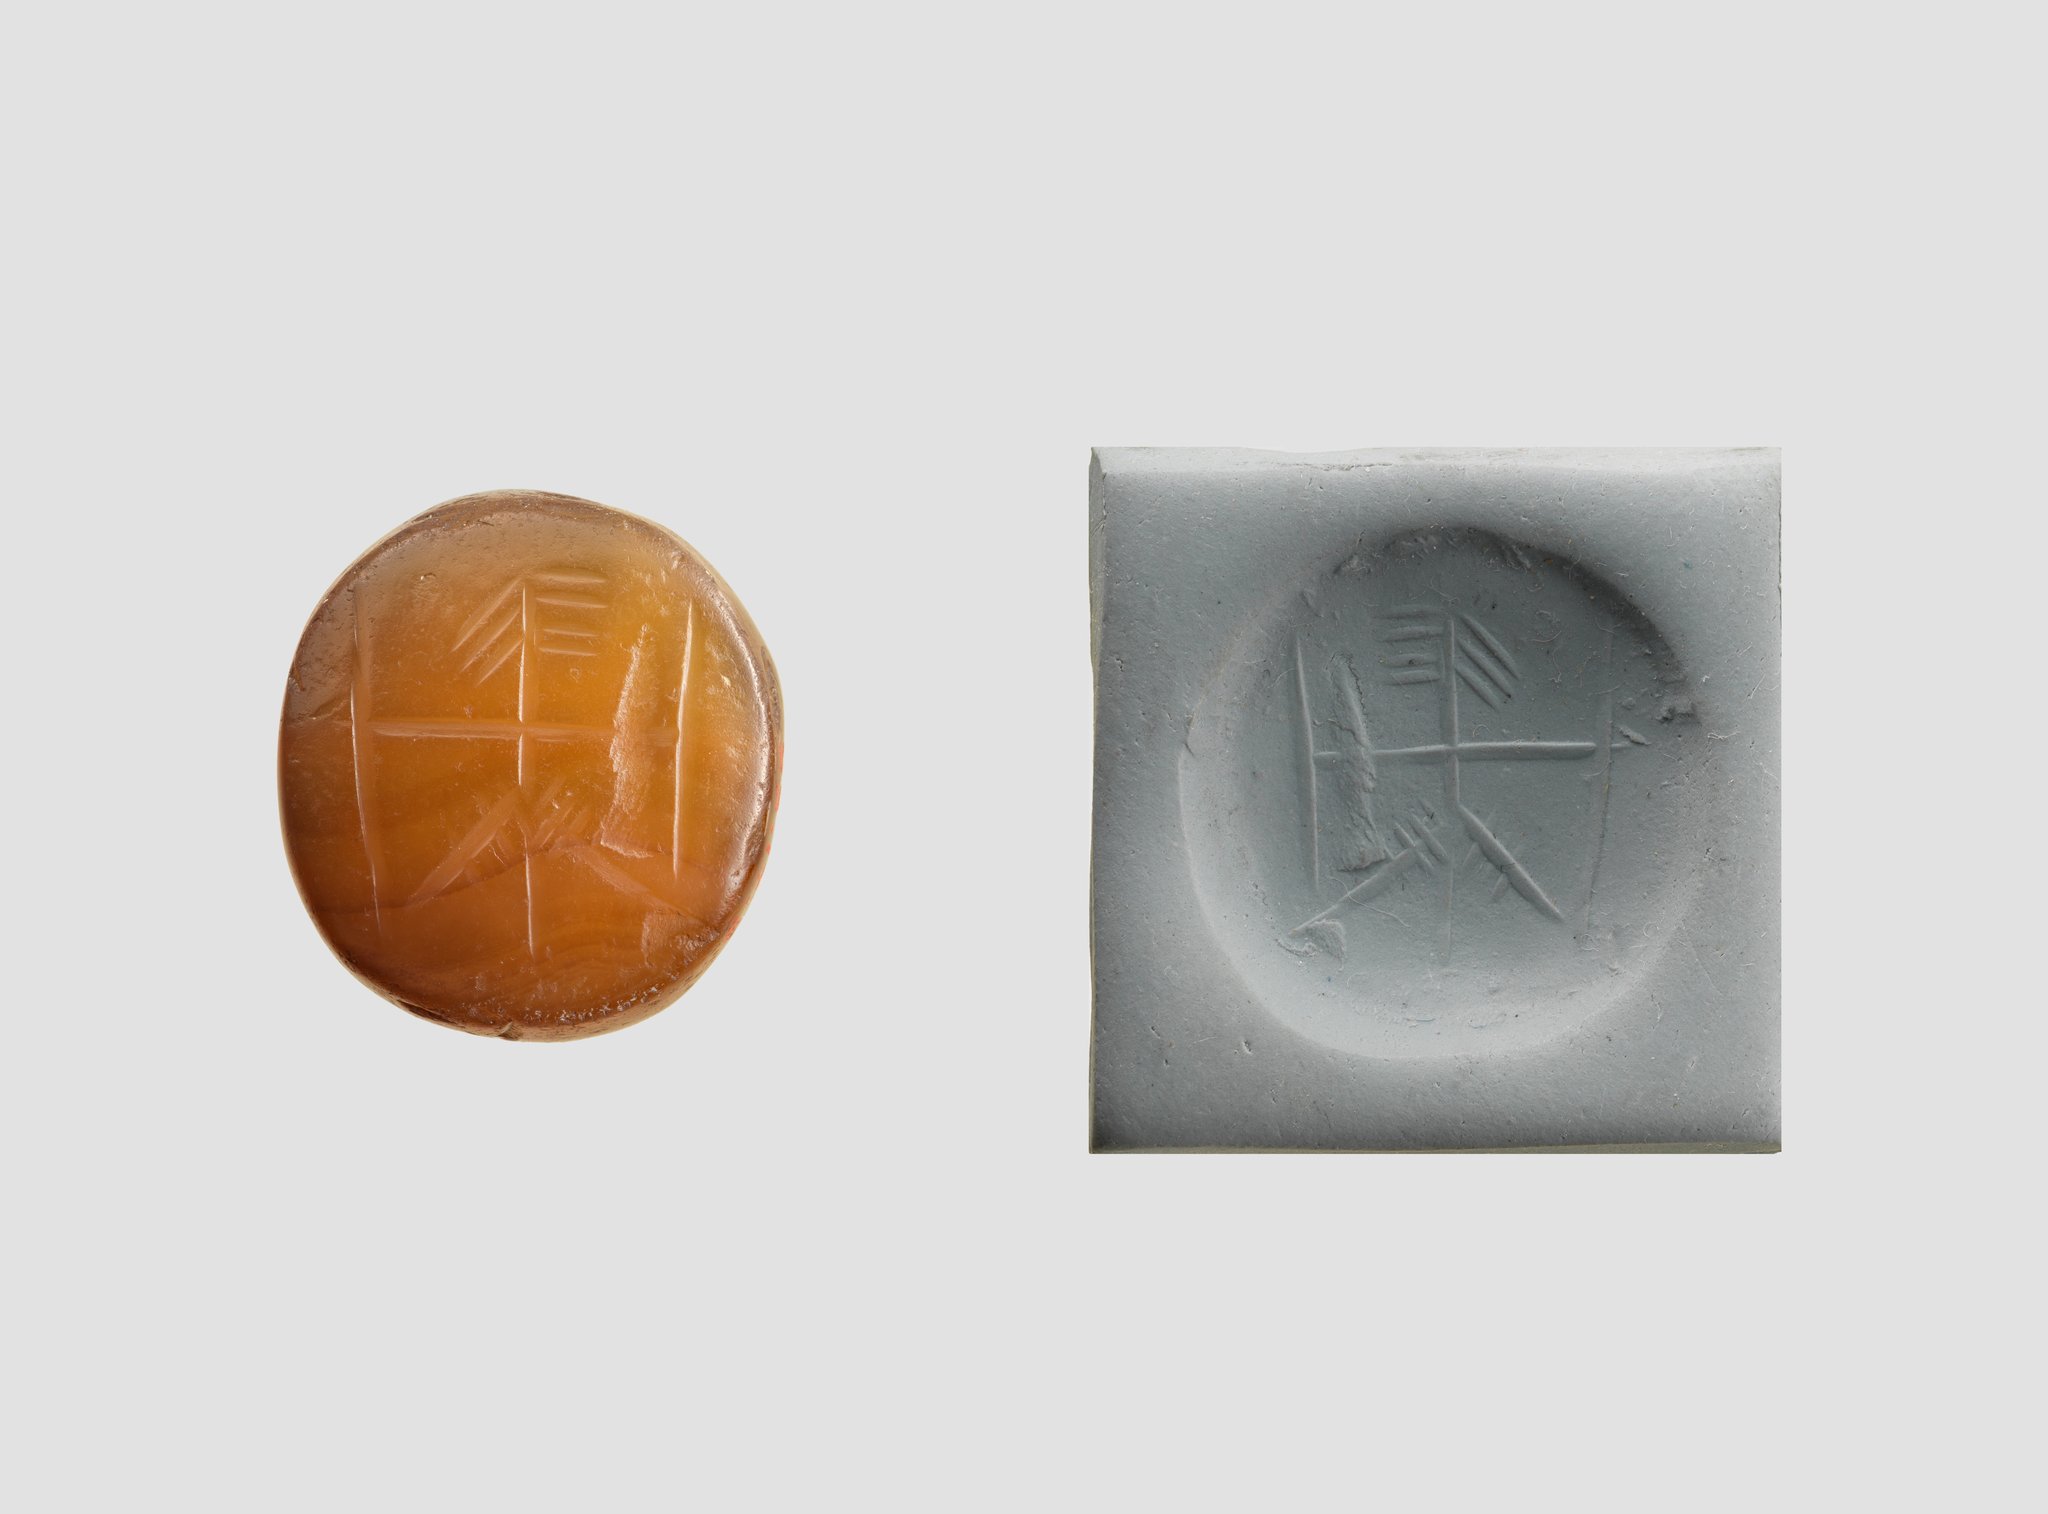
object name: stamp seal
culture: sasanian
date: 201-700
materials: stone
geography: iran or mesopotamia